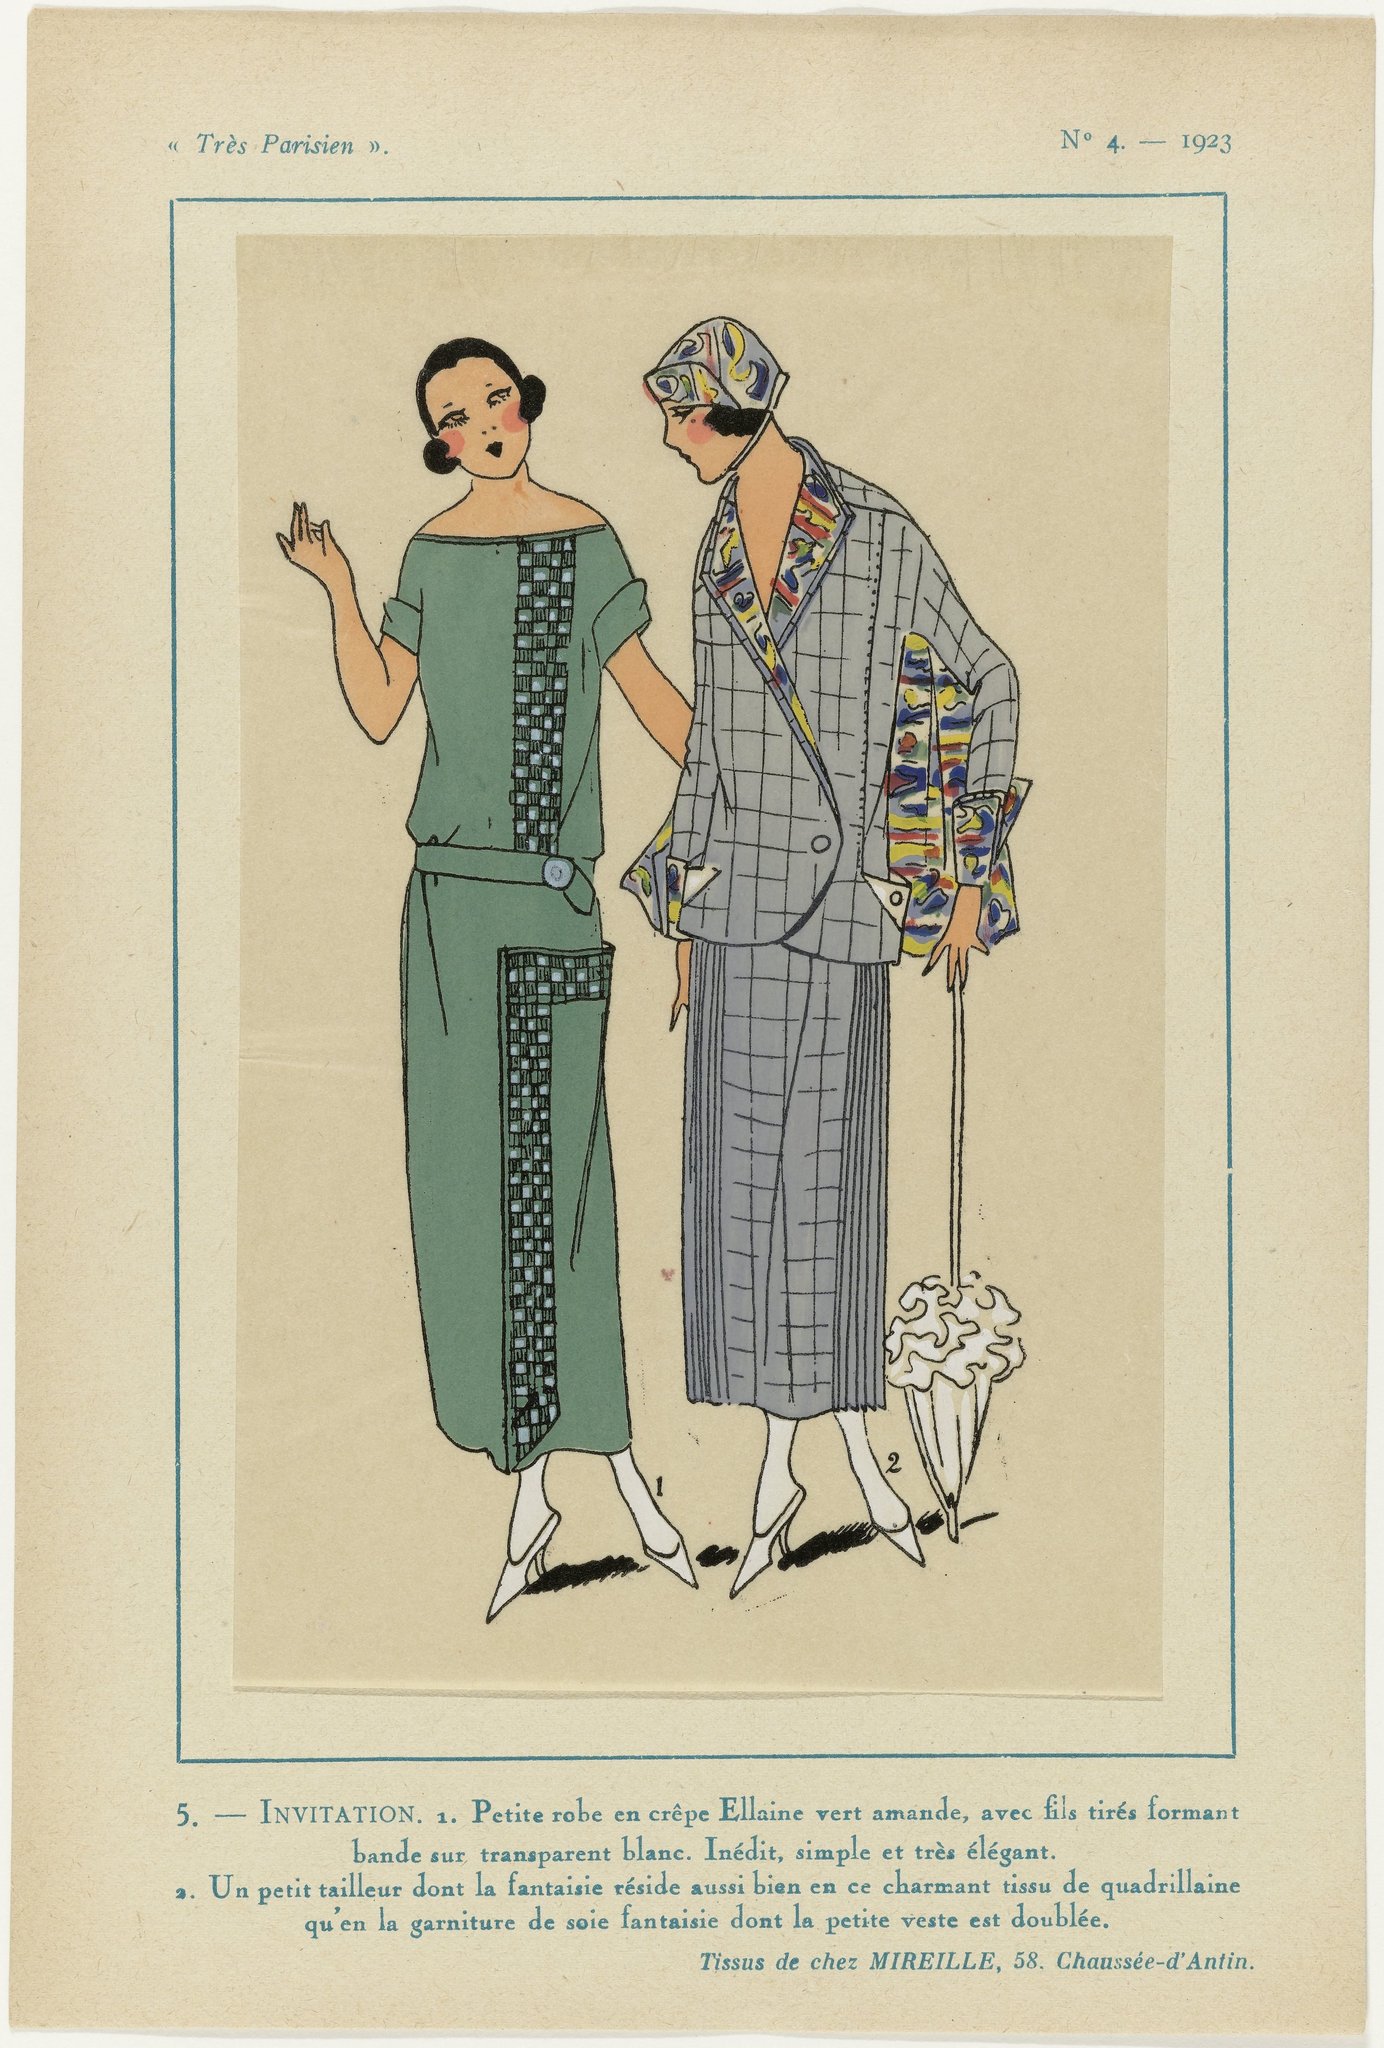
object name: fashion print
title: Très Parisien, 1923, No. 4: 5. - INVITATION. 1. Petite robe...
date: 1923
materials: paper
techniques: hand coloring, letterpress printing, lithography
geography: paris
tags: walking-stick, staff, cane (+ women's clothes), border, ribbon, braid (+ women's clothes), ensembles of pieces of clothing (suit) (+ women's clothes), coat (+ women's clothes), fashion plates, head-gear: hat (+ women's clothes), skirt (+ women's clothes), dress, gown (+ women's clothes)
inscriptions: caption: ‘5. - INVITATION. 1. Petite robe en crêpe Ellaine vert amande, avec fils tirés formant bande sur transparent blanc. Inédit, simple et très élégant. 2. Un petit tailleur dont la fantaisie réside aussi bien en ce charmant tissu de quadrillaine qu'en la garniture de soie fantaisie dont la petite veste est doublée. / Tissus de chez MIREILLE, 58, Chaussée - d'Antin.’, title: ‘Très Parisien / No 4. - 1923’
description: 1. Jurk van amandelgroene 'crêpe Ellaine' gegarneerd met een geruite band. 2. Een tailleur (mantelpak) van geruite stof warvan de jas is gevoerd met zijde ('soie fantaisie'). Accessoires: hoed van dezelfde stof de voering, parasol, pumps. Stoffen van Mireille. Prent uit het modetijdschrift Très Parisien (1920-1936).